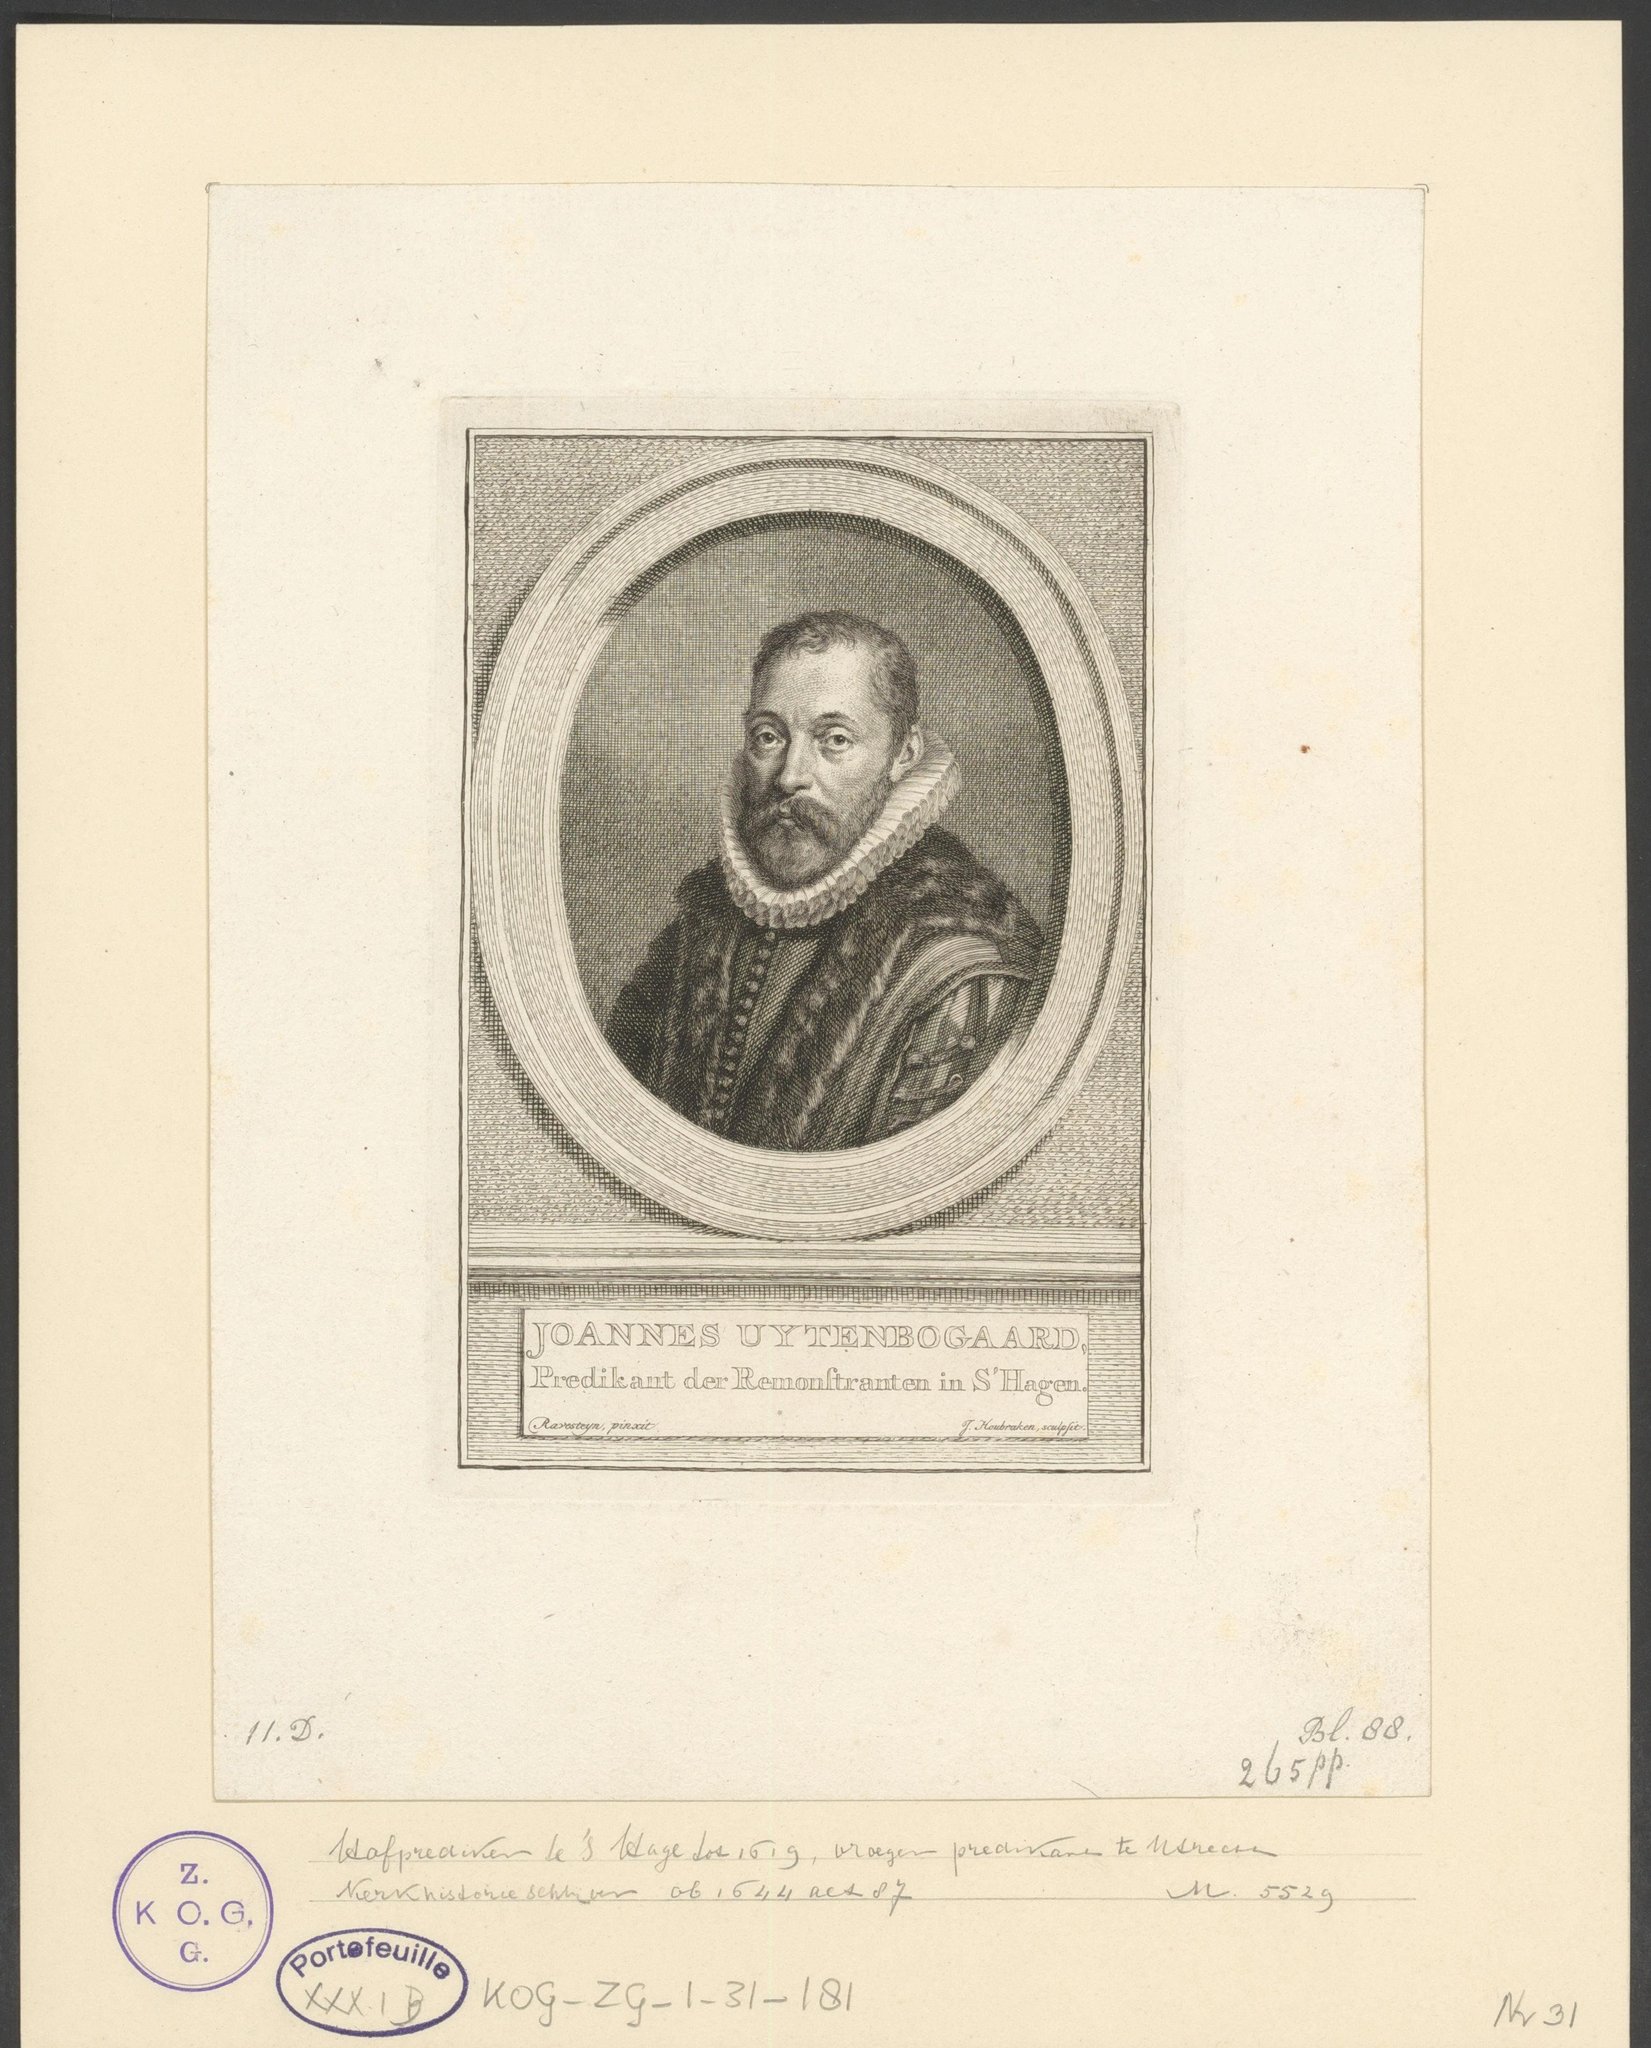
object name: print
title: Portret van Johannes Wtenbogaert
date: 1749-1796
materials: paper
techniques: engraving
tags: utrecht, the hague, historical persons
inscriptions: collector's mark: Lugt 1641, stamp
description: Deze prent is oorspronkelijk bedoeld als aanvulling op Jan Wagenaars ‘Vaderlandsche historie’* en was zo vanaf 1796 verkrijgbaar bij Johannes Allart te Amsterdam. Voor de advertentie waarin Allart de 60 portretten en 7 platen, allen gegraveerd door Houbraken, ter aanvulling op Wagenaars ‘Vaderlandsche historie’ aanbiedt, zie RP-P-OB-77.766. *Van dit werk zijn in de achttiende eeuw meerdere uitgaves verschenen, zoals: Wagenaar, Jan. Vaderlandsche historie, vervattende de geschiedenissen der Vereenigde Nederlanden (…). 21 delen. Amsterdam: Isaak Tirion, 1749-1759. Wagenaar, Jan. Vaderlandsche historie, vervattende de geschiedenissen der nu Vereenigde Nederlanden (…). 21 delen. Amsterdam: weduwe Isaak Tirion, 1770. Wagenaar, Jan. Vaderlandsche historie, vervattende de geschiedenissen der nu Vereenigde Nederlanden (…). 21 delen. Amsterdam, Leiden, Dordrecht en Harlingen: P. Schouten e.a., 1782. Wagenaar, Jan. Vaderlandsche historie, vervattende de geschiedenissen der nu Vereenigde Nederlanden (…). 21 delen. Amsterdam: Johannes Allart, 1790-1796.